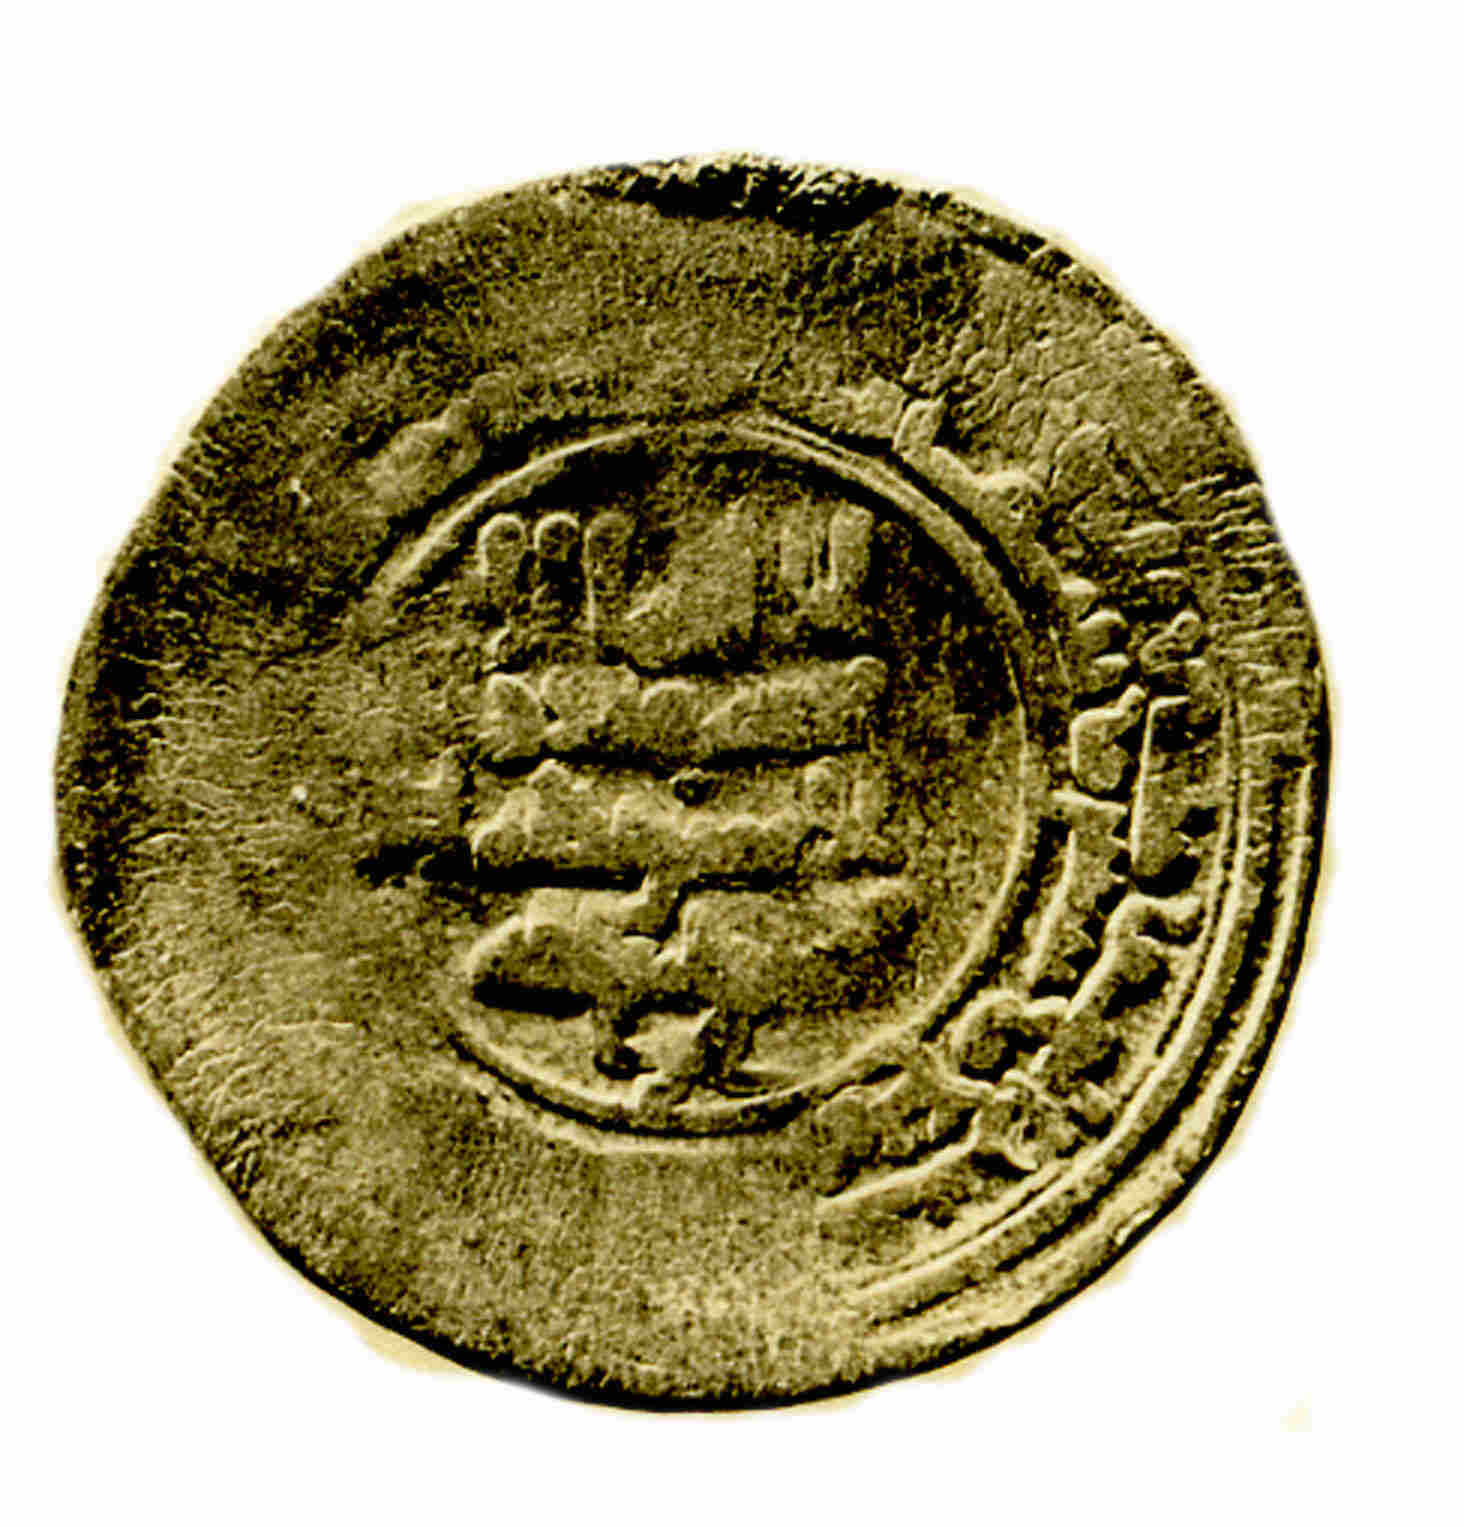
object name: coin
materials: silver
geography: jurjan